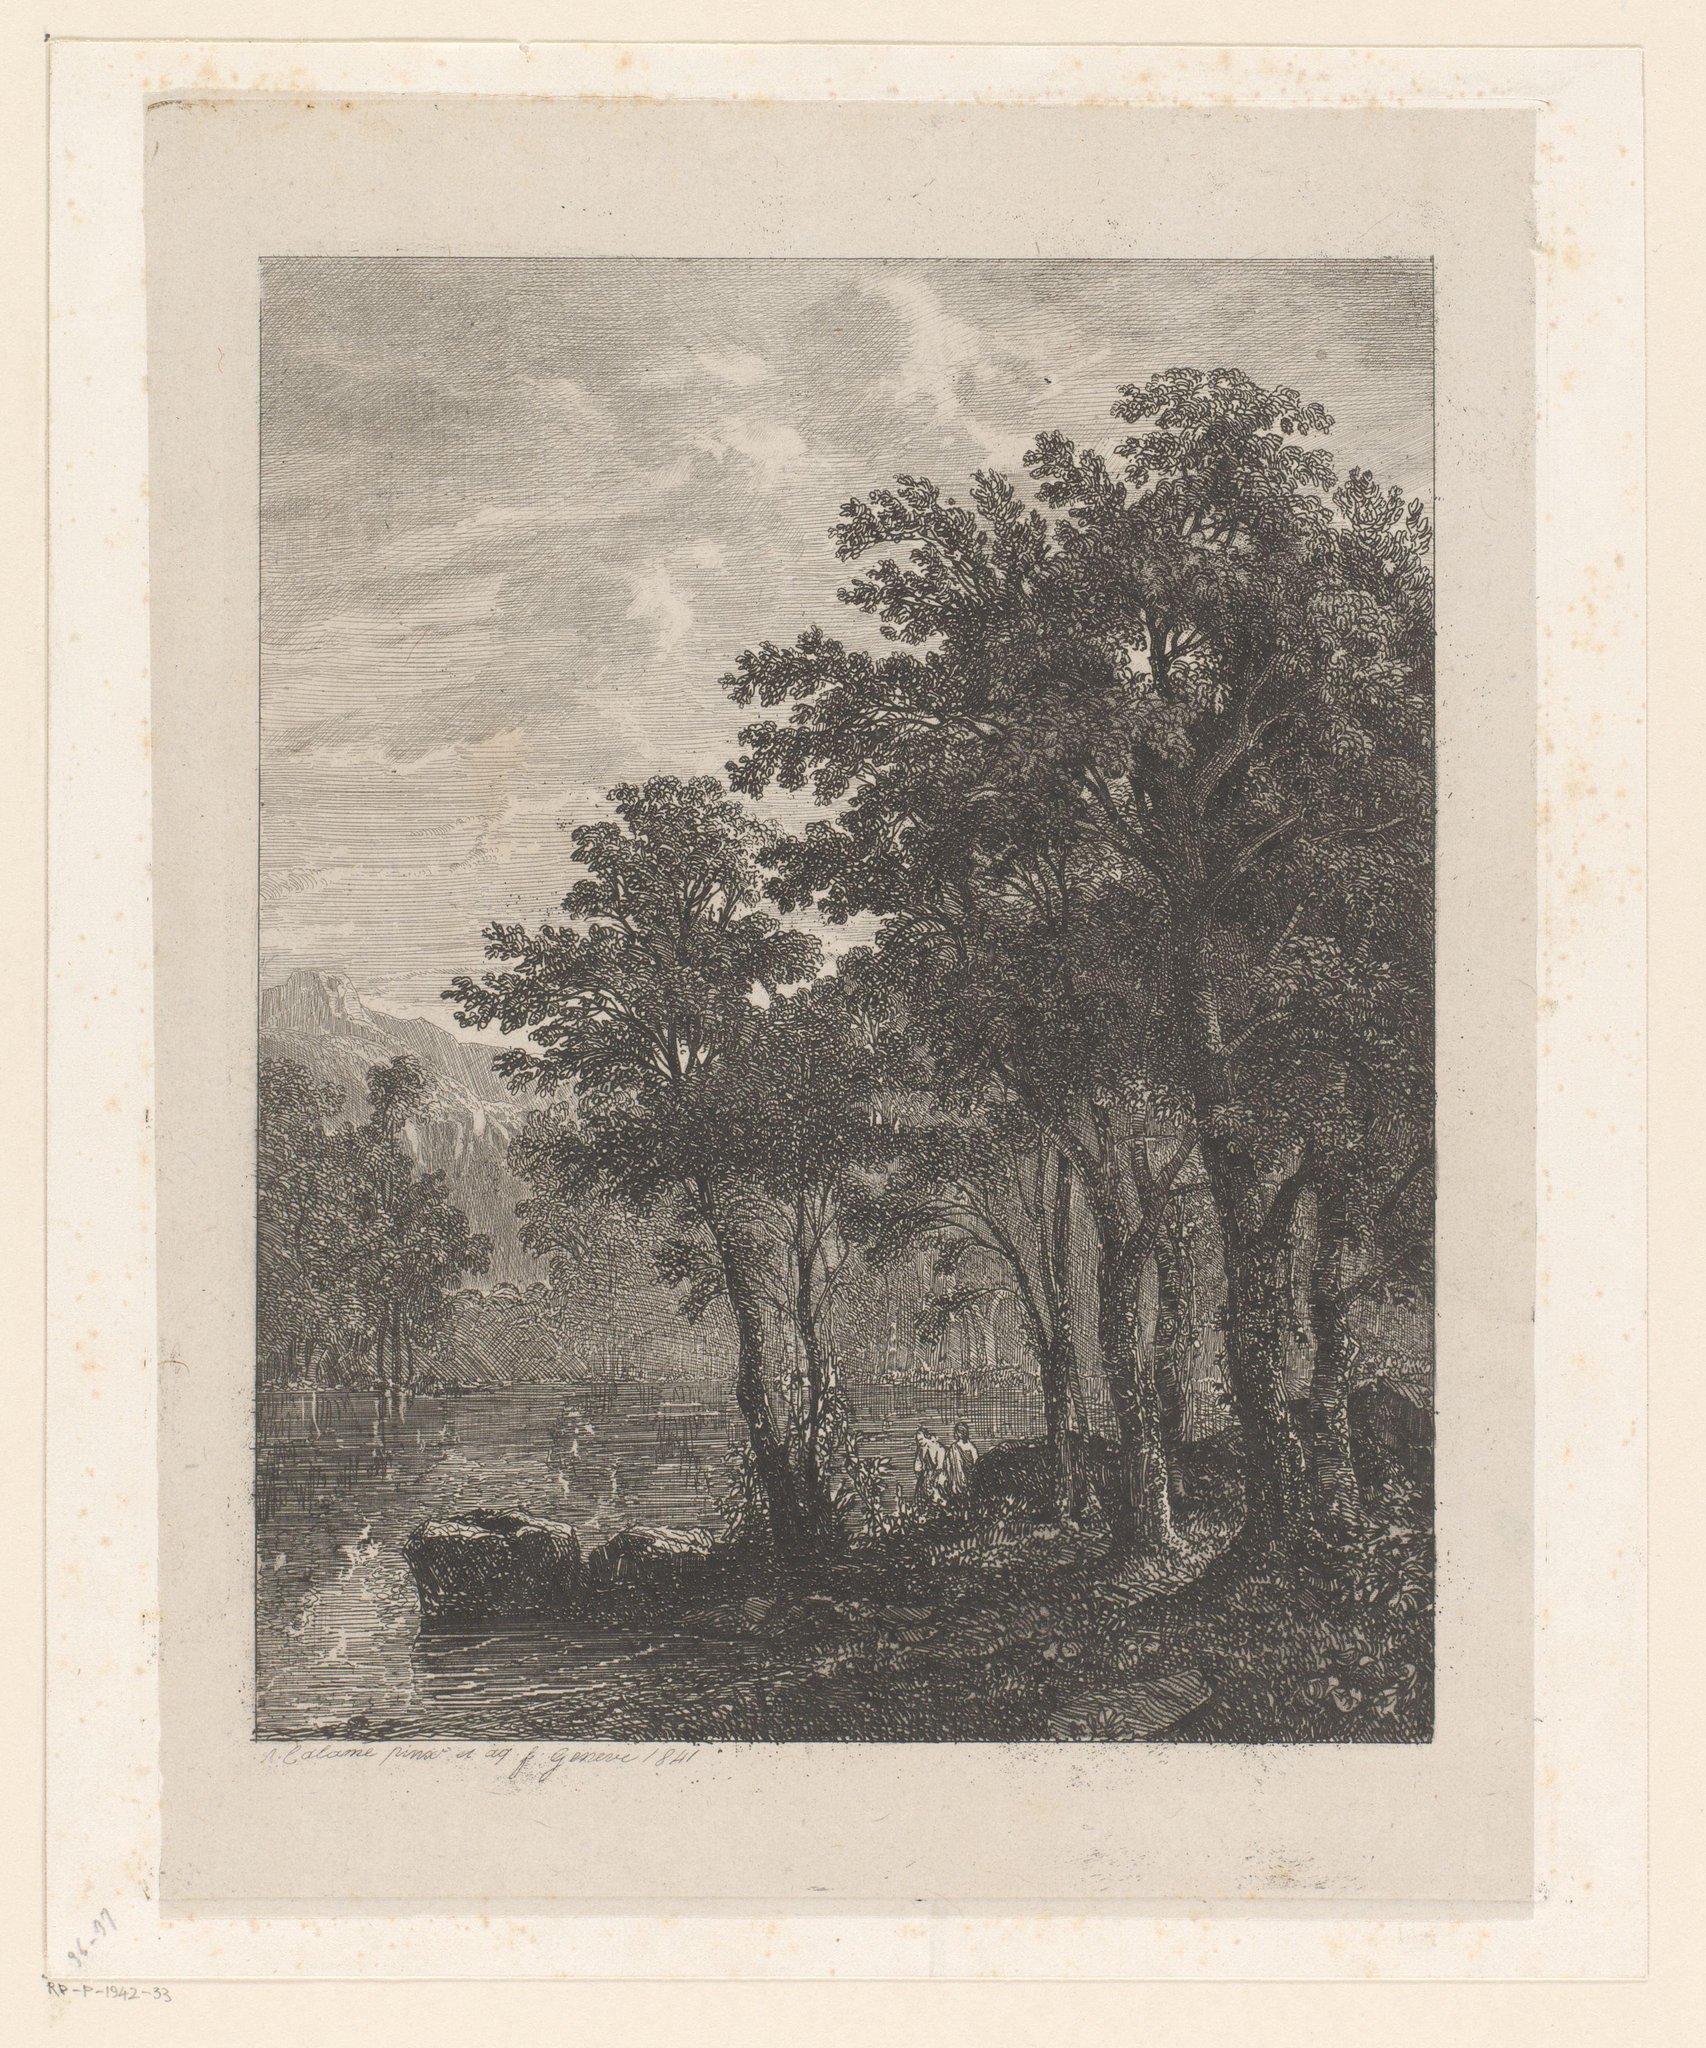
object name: print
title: Berglandschap met loofbomen en twee figuren aan een meer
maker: alexandre calame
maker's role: draughtsman, painter, print maker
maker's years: 1810-1864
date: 1841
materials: paper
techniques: etching, roulette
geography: geneva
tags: lake, deciduous forest, landscapes (+ landscape with figures, staffage), mountains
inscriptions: collector's mark: Lugt 2760, collector's mark: Lugt 2228